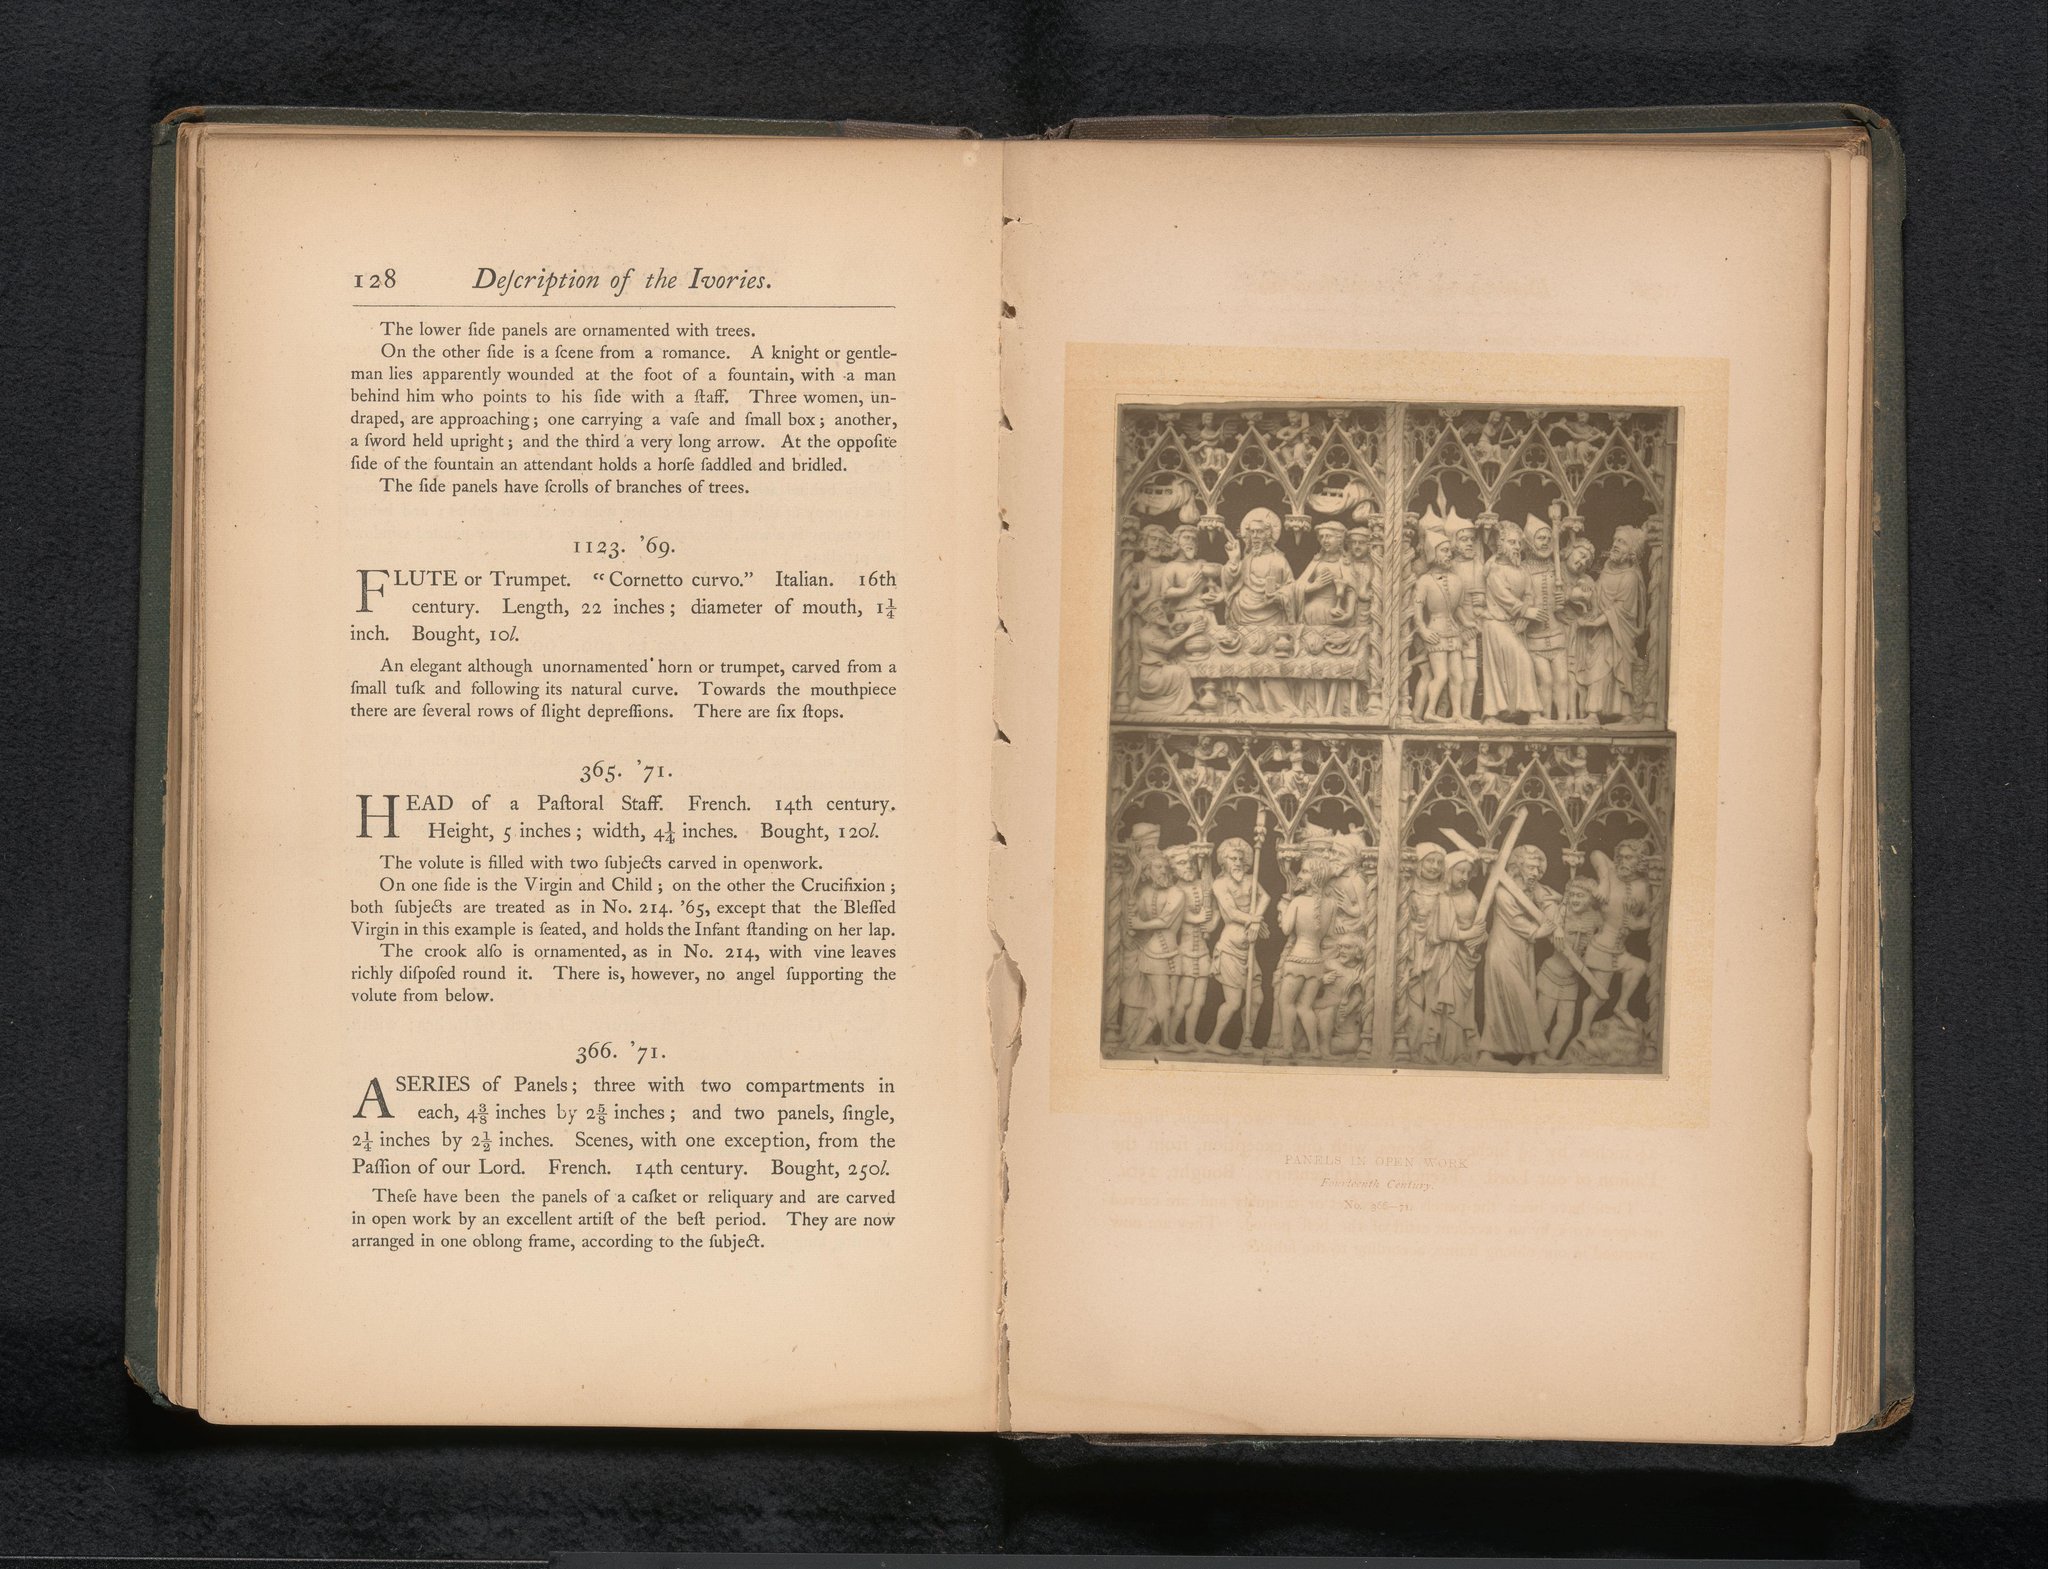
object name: page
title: Panels in open work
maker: Anonymous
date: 1867-1872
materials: paper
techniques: woodburytype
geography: london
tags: passion of christ, sculpture (+ relief ~ sculpture)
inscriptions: number: ‘No. 366-71.’, inscription: ‘Fourteenth Century.’